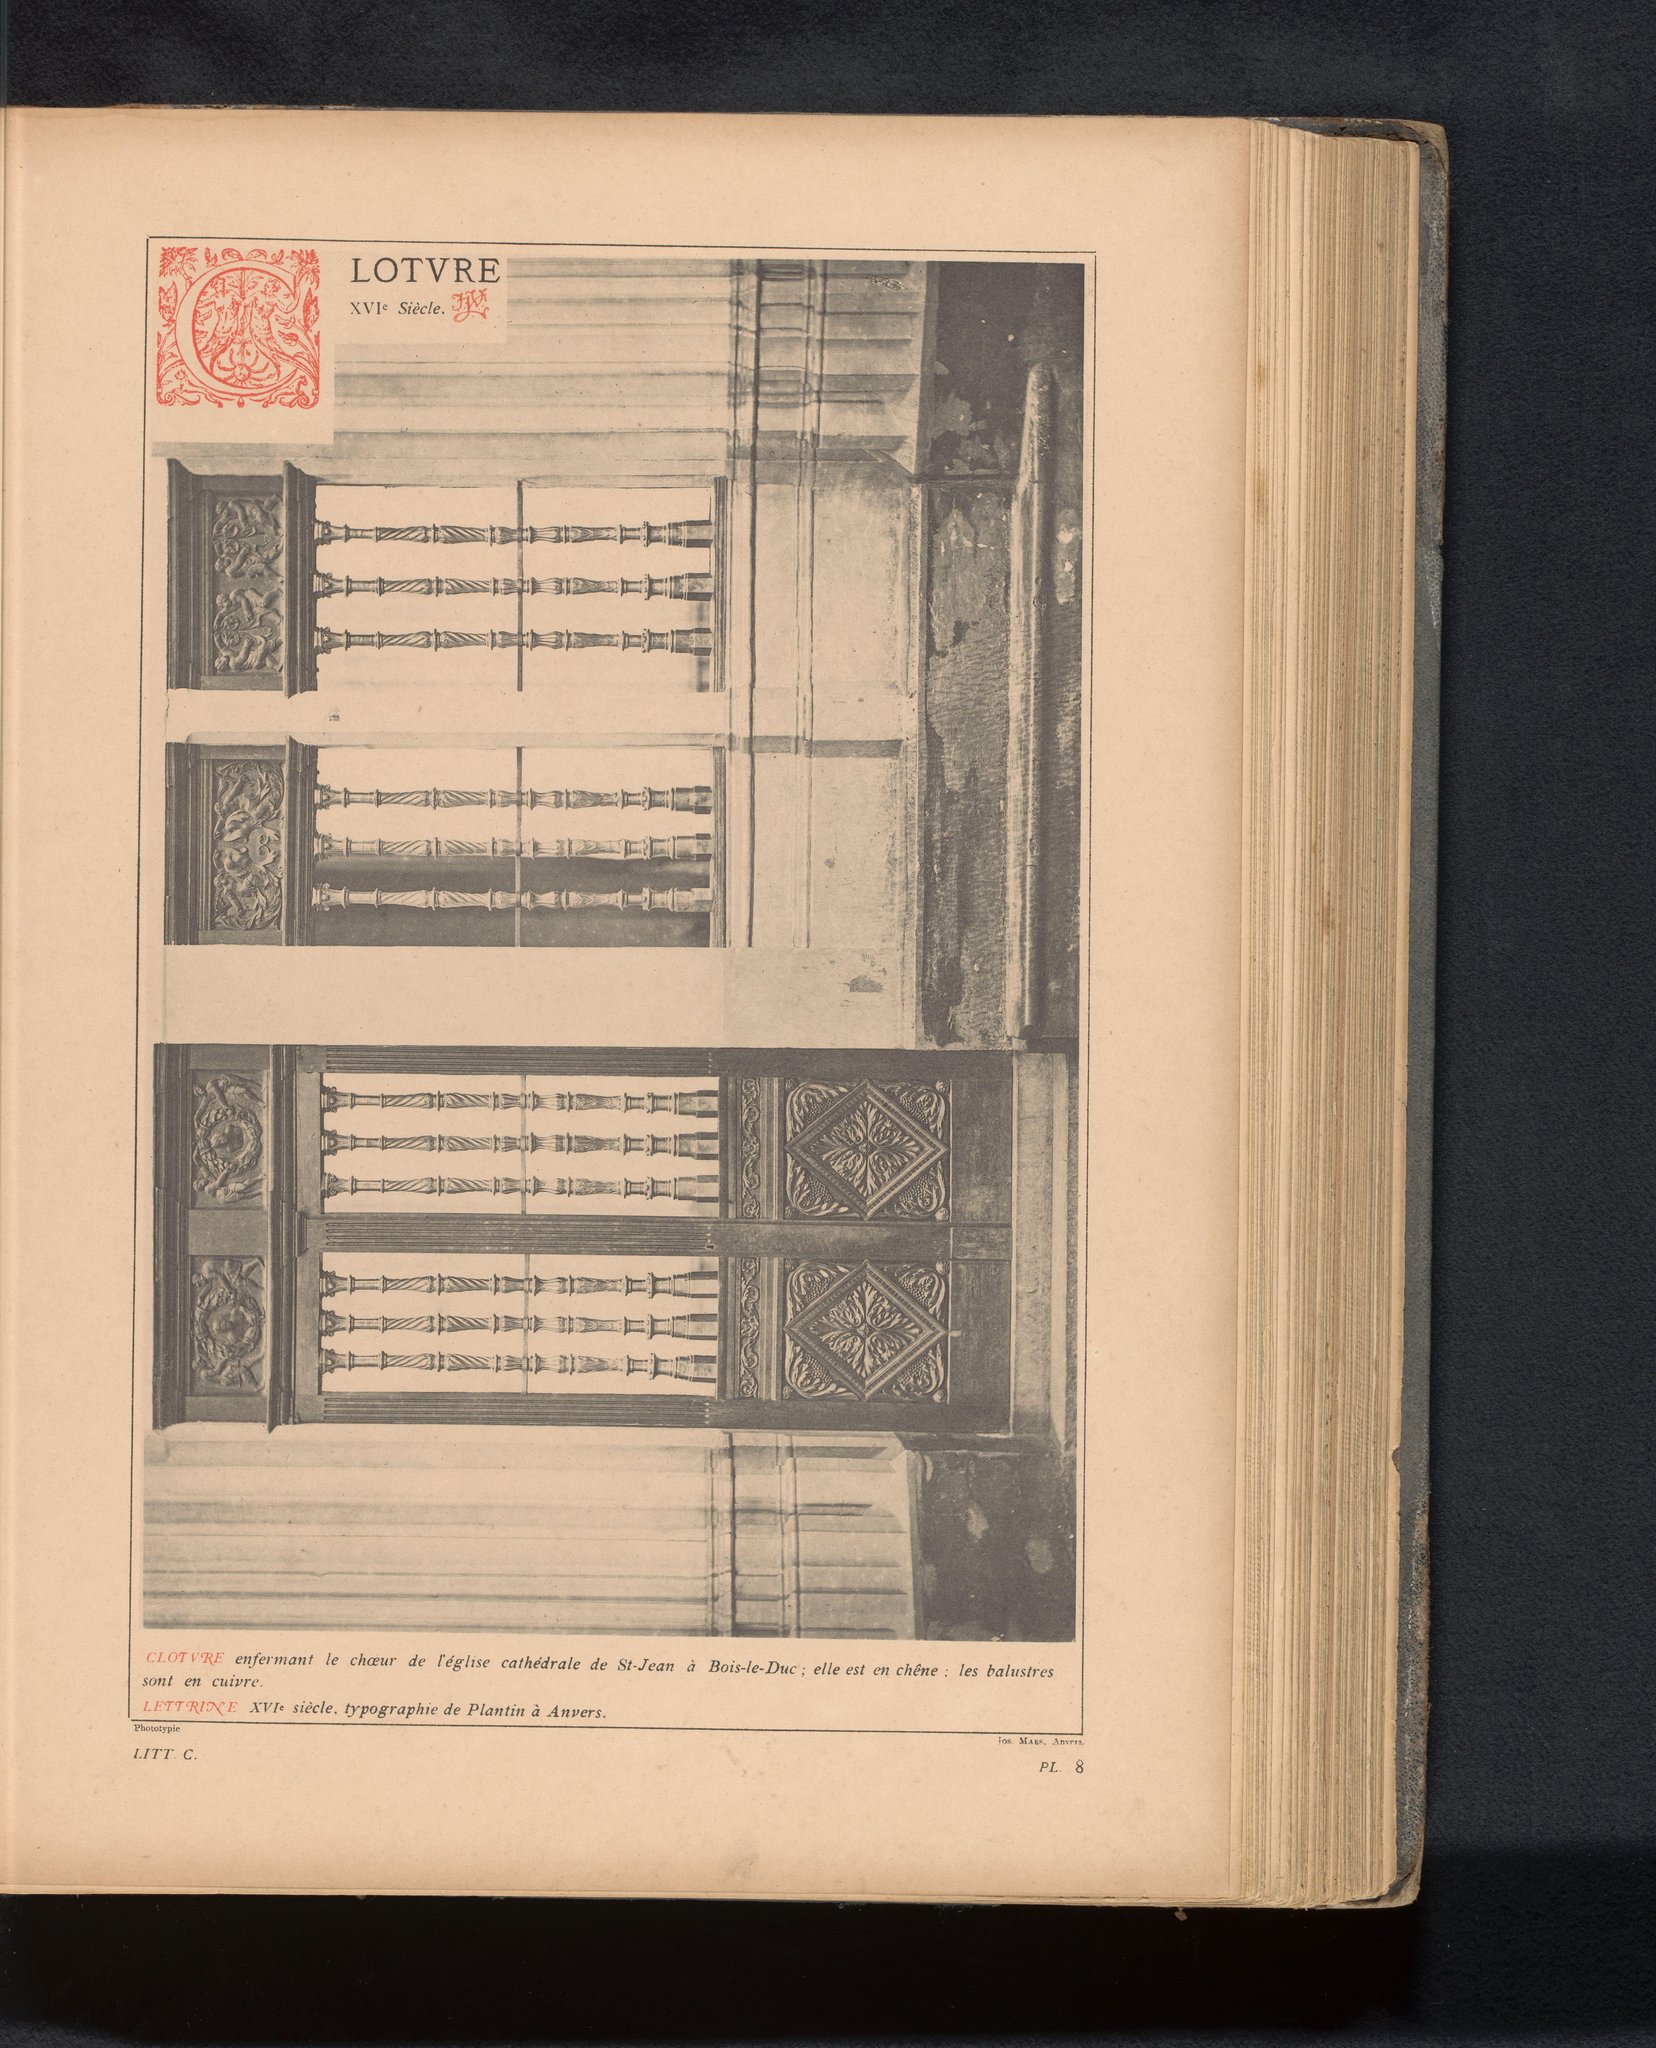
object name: page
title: Cloture, XVIe Siècle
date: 1875-1880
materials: paper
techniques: photograph, photolithography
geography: antwerp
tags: rood-screen, choir-screen; iconostasis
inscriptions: inscription: ‘Cloture enfermant le (...)’, inscription: ‘LITT. C. - PL. 8’, monogram: ‘JJvY’